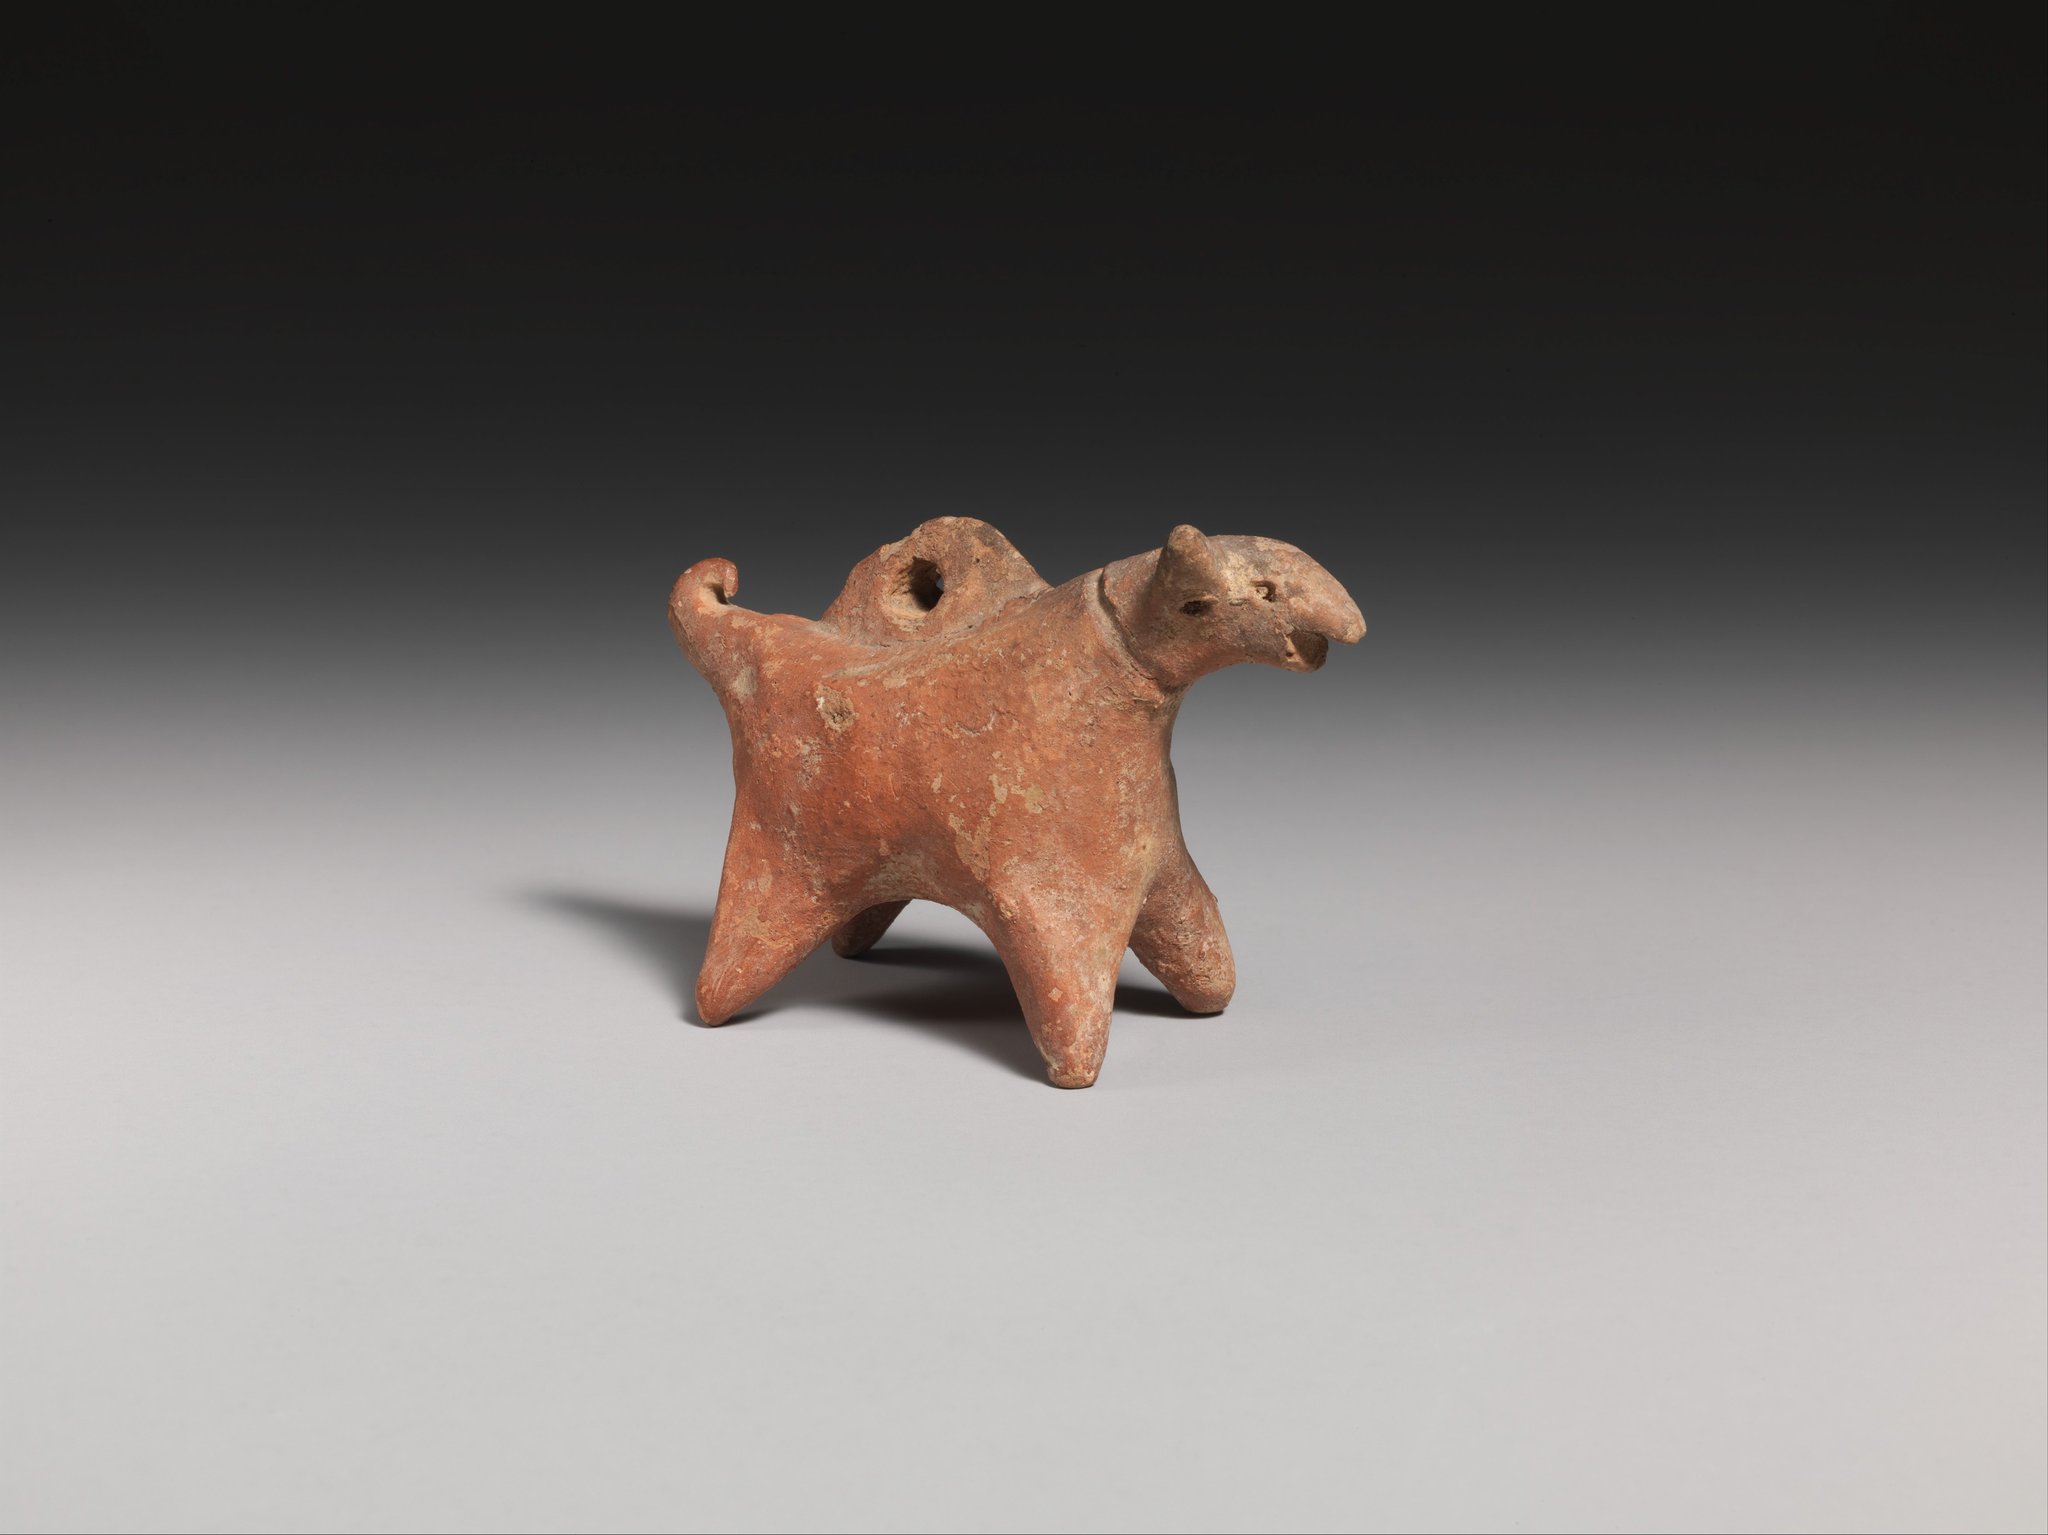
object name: figurine, animal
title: Terracotta dog (?) figurine with suspension hole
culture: cypriot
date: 1900-1800 BCE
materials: terracotta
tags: dogs